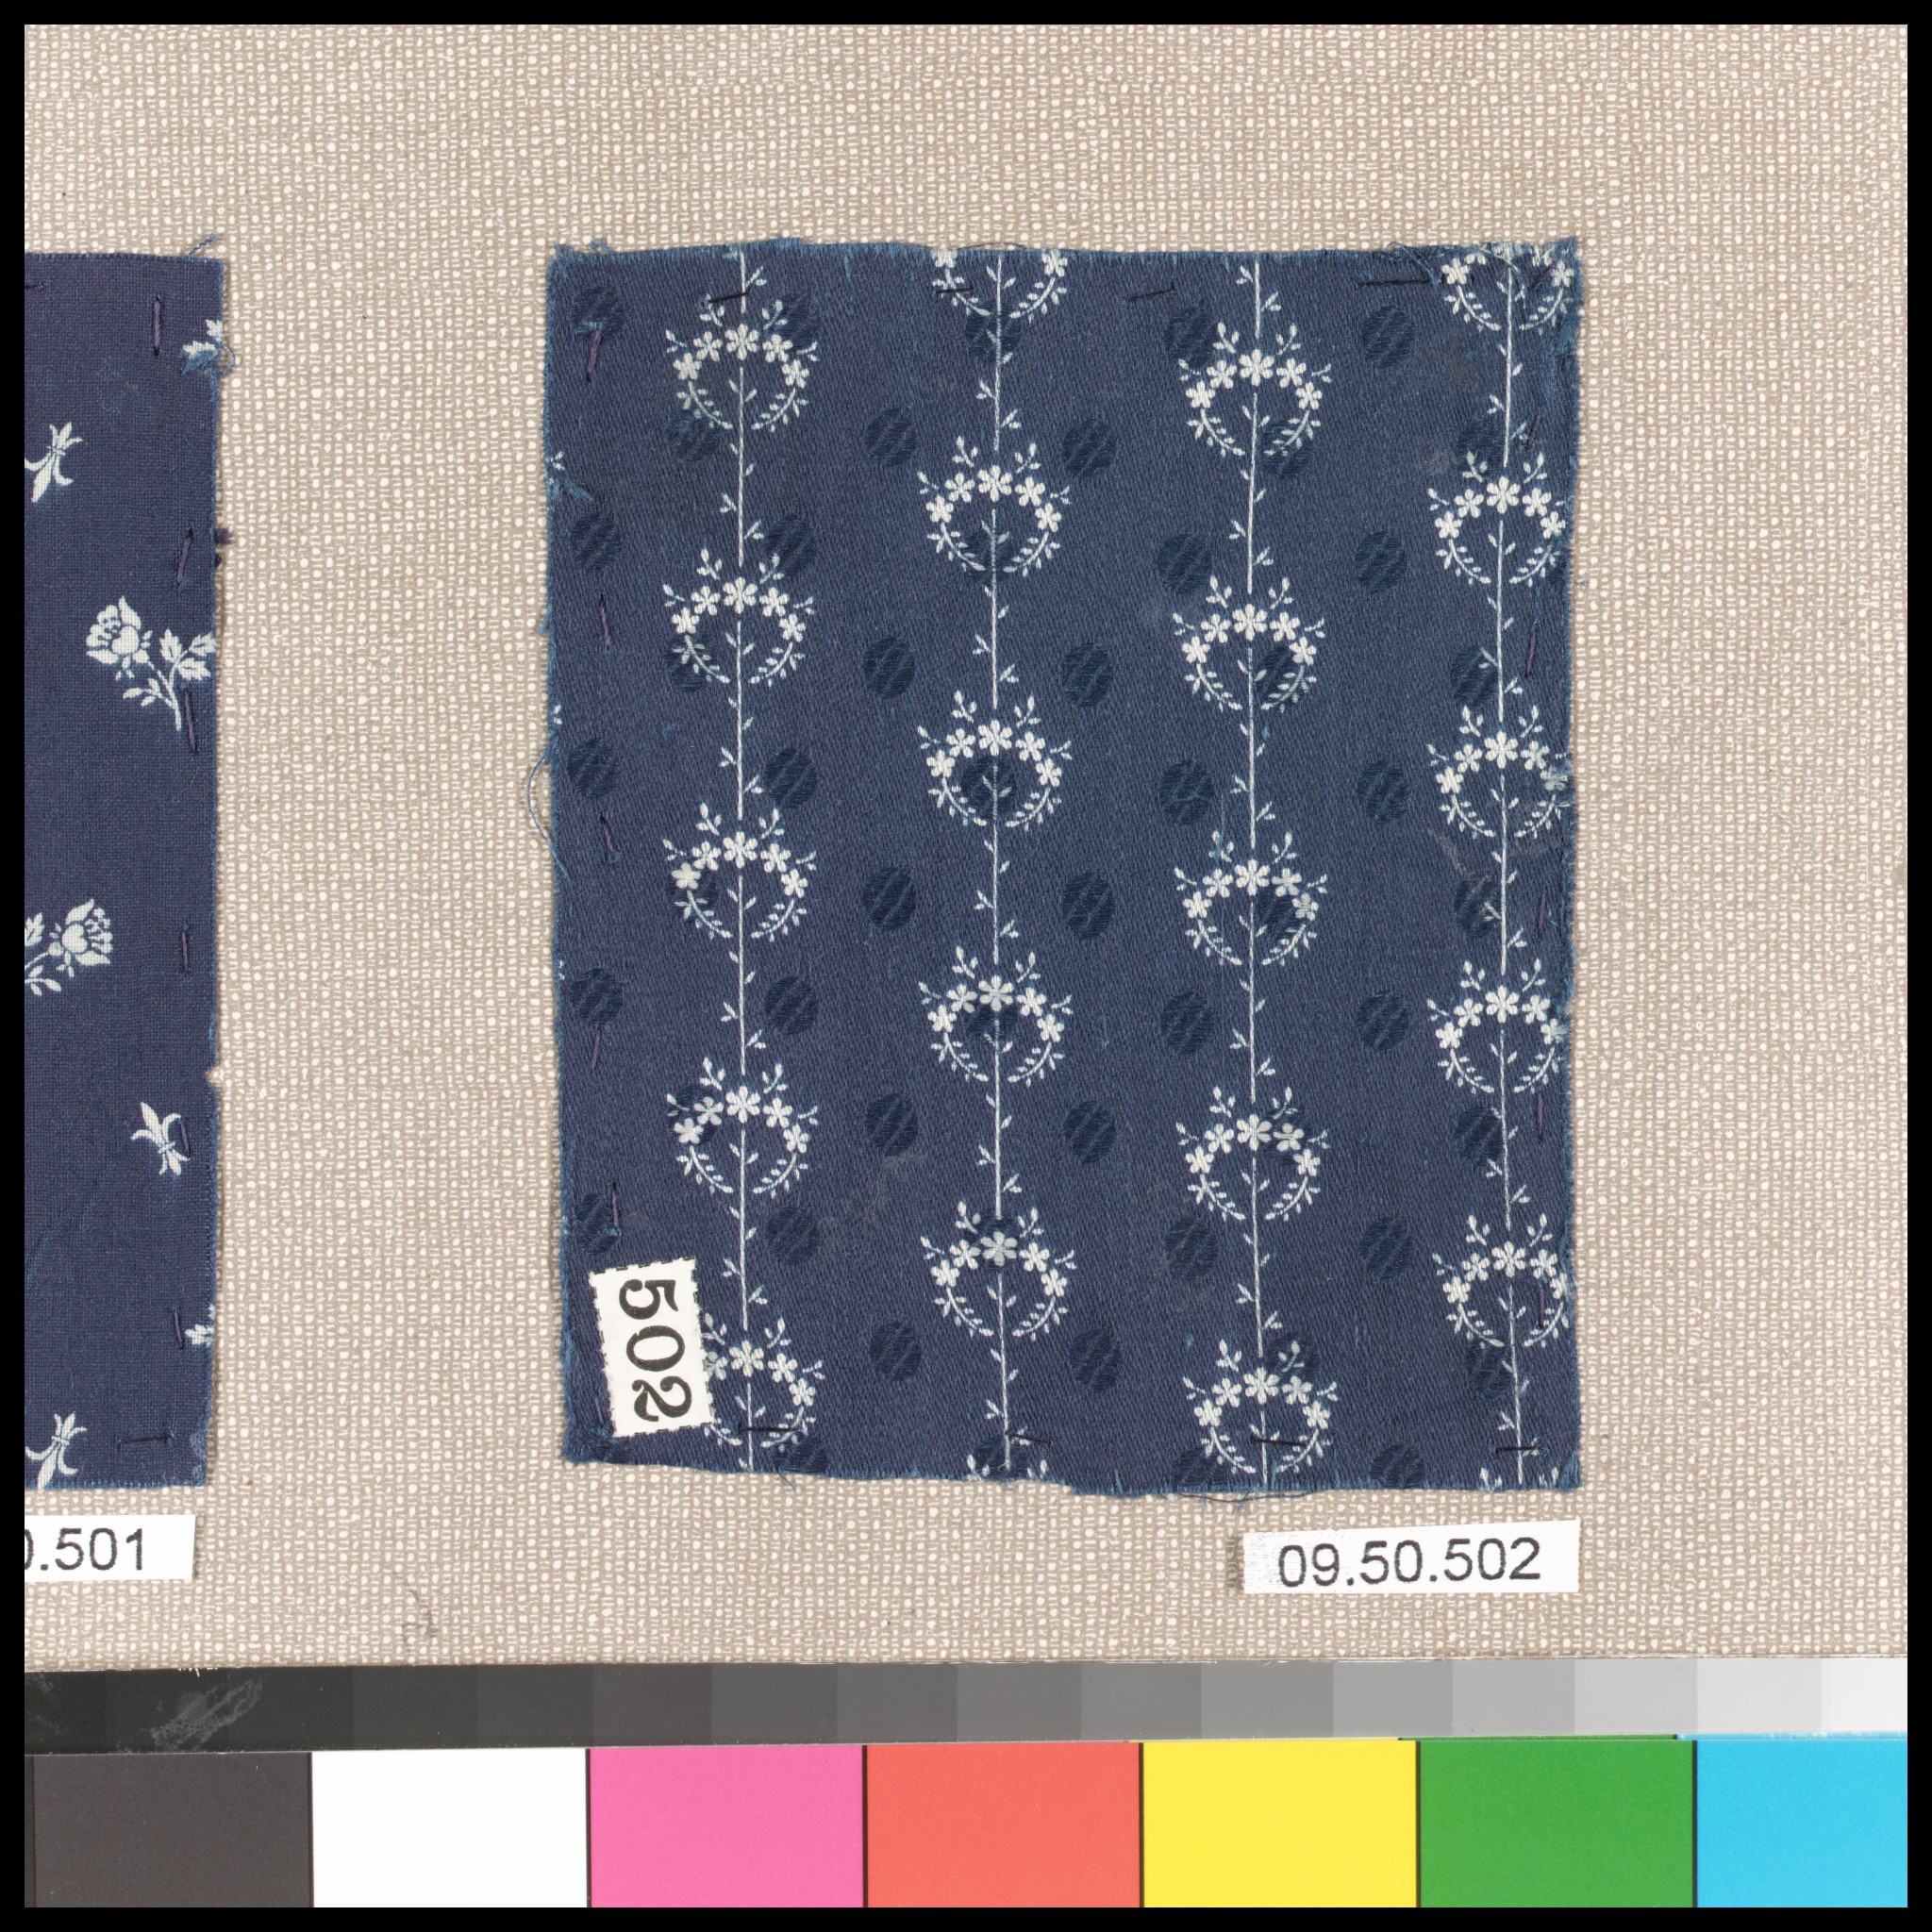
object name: piece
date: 1801-1900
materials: cotton